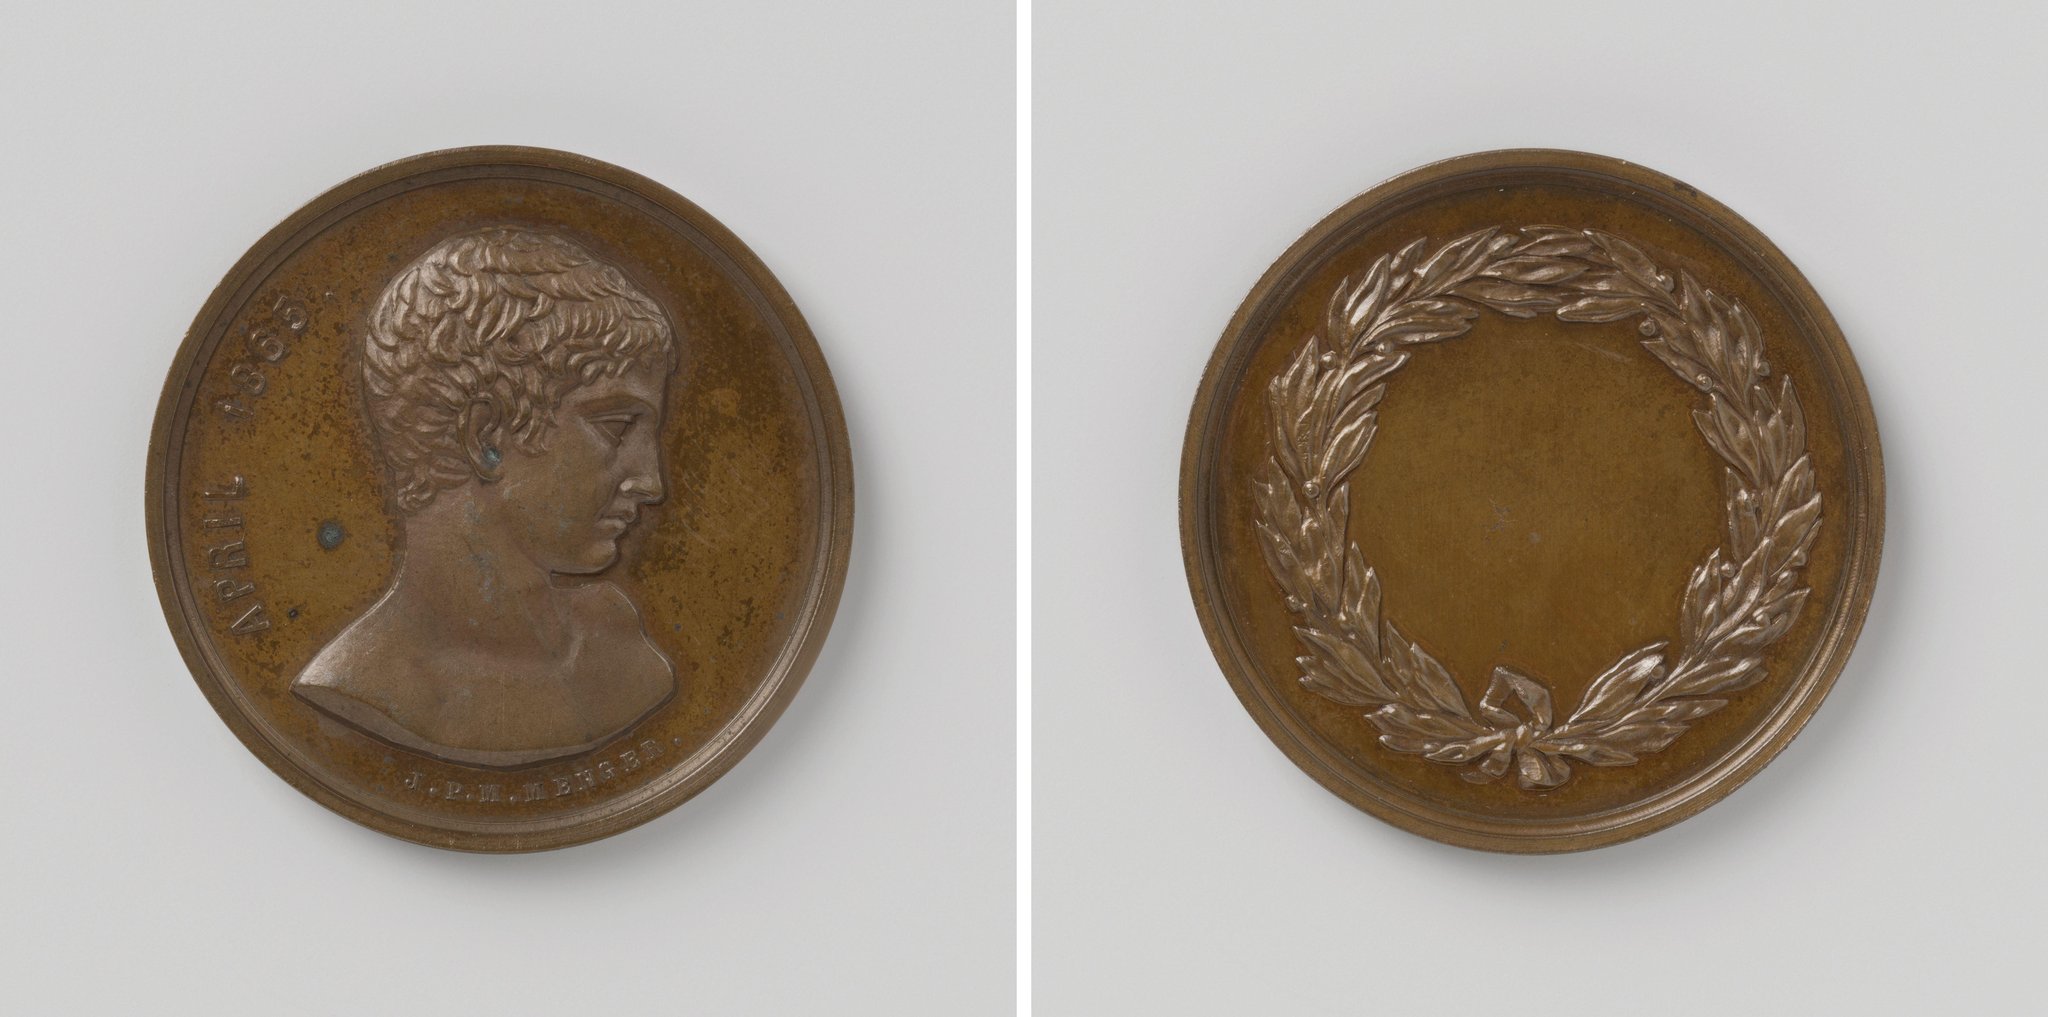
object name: proefslag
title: Antinous, tweede muntproef van de stempelsnijder J.P.M. Menger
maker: johan philip mathias menger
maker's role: medailleur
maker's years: 1845-1905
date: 1804-1865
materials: bronze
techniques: striking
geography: utrecht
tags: nijl, antinoüs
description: Voorzijde: borststuk jongeman binnen omschrift. Keerzijde: blanco veld binnen lauwerkrans